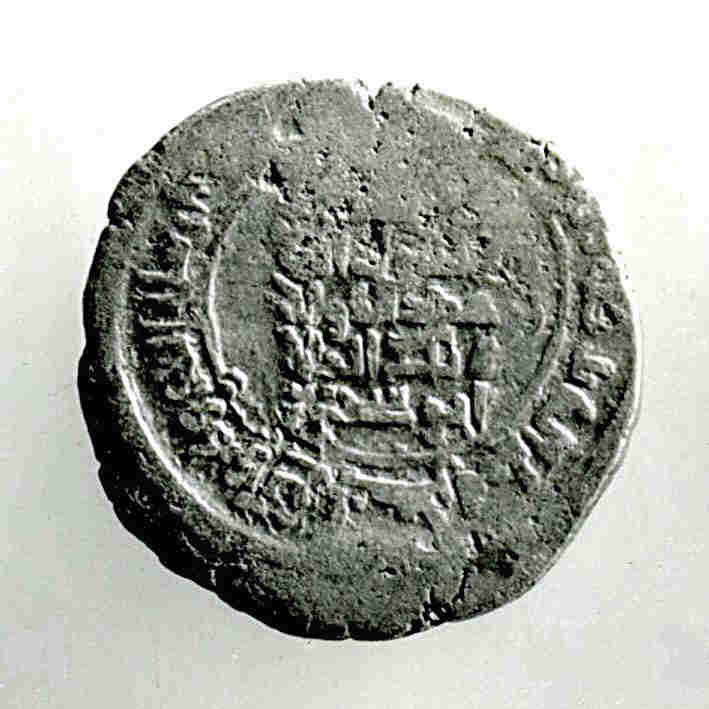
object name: coin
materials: silver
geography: iran